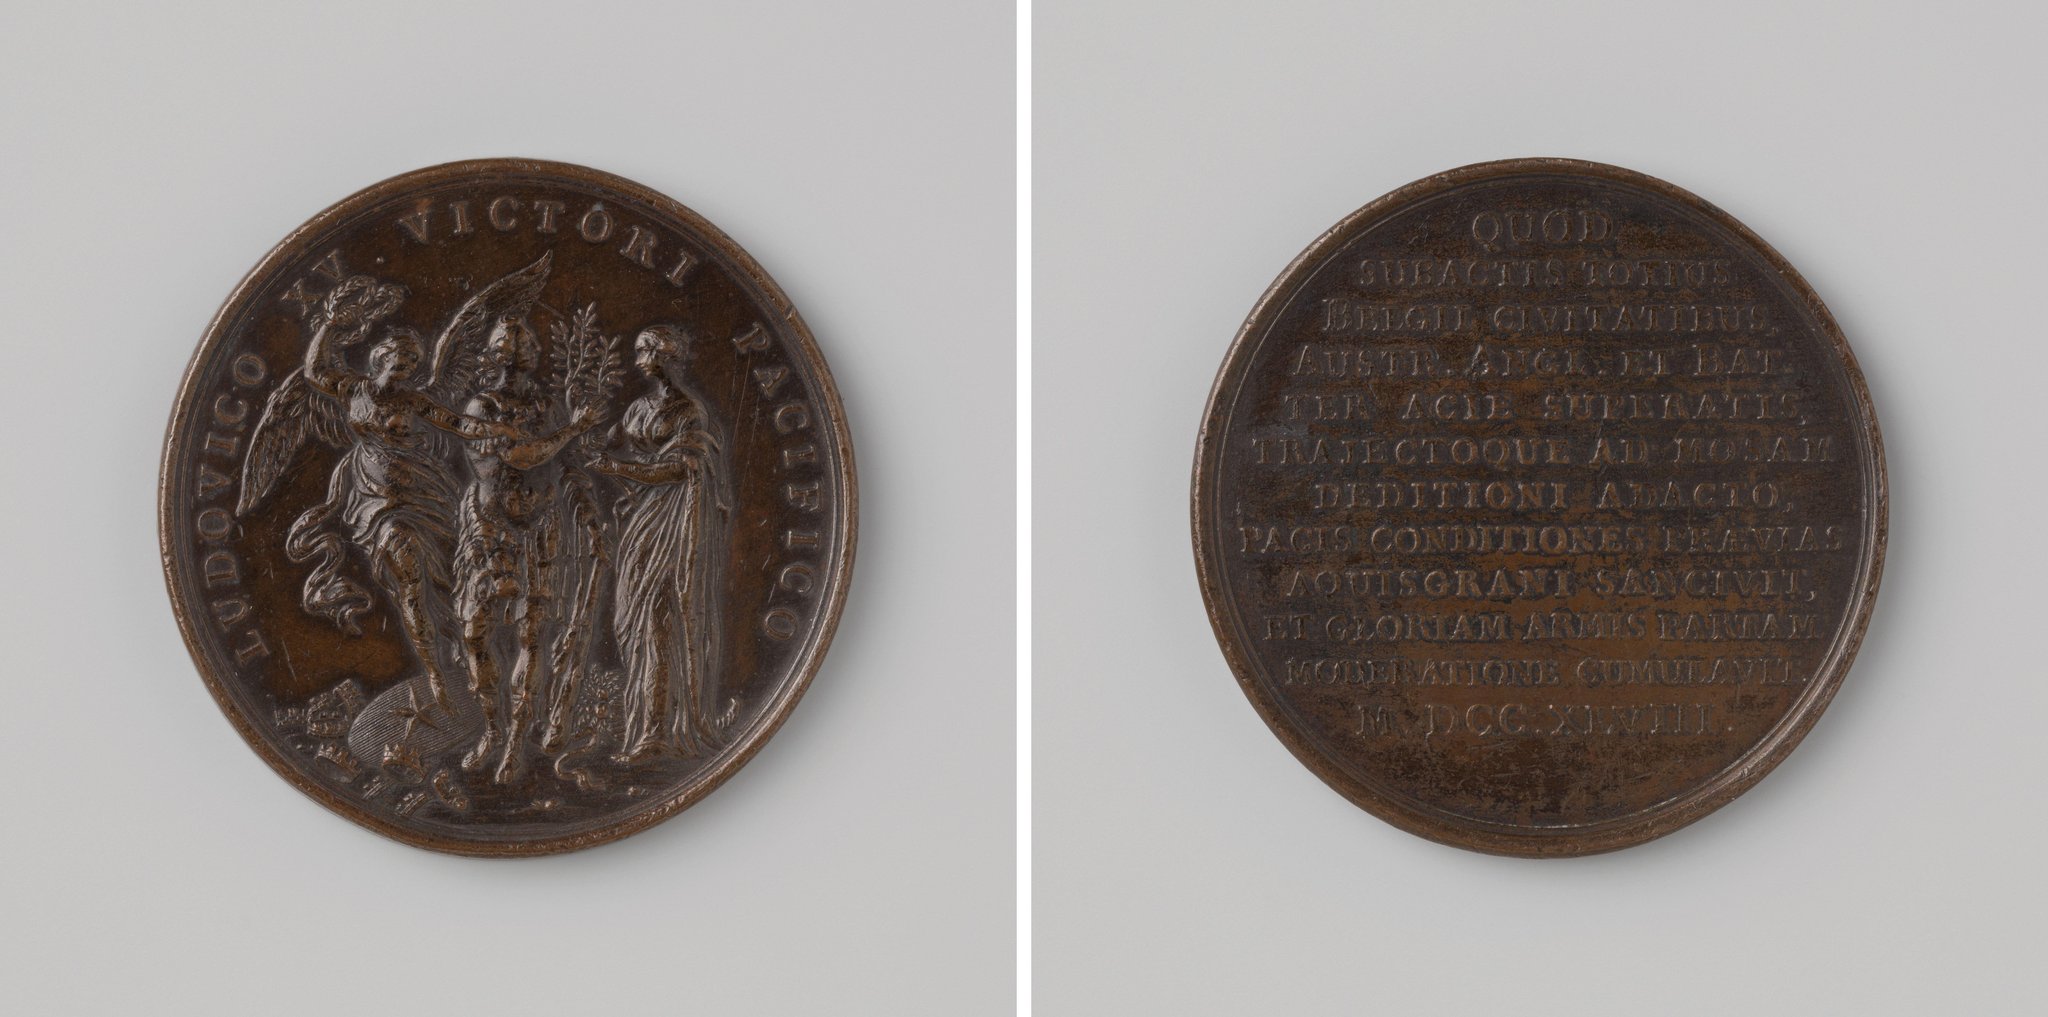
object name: history medal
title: Tekenen van de voorlopige vrede te Aken en inname van Maastricht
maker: Anonymous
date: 1748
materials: bronze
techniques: striking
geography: paris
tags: louis xv of france, maastricht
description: Bronzen penning. Voorzijde: Lodewijk XV met knuppel van Herkules en leeuwehuid rond zijn middel, wendt zich af van de Overwinning die een lauwerkrans in de hand houdt om van de Vrede een olijftak te ontvangen; op de grond liggen kronen en een wapenschild. Keerzijde: opschrift